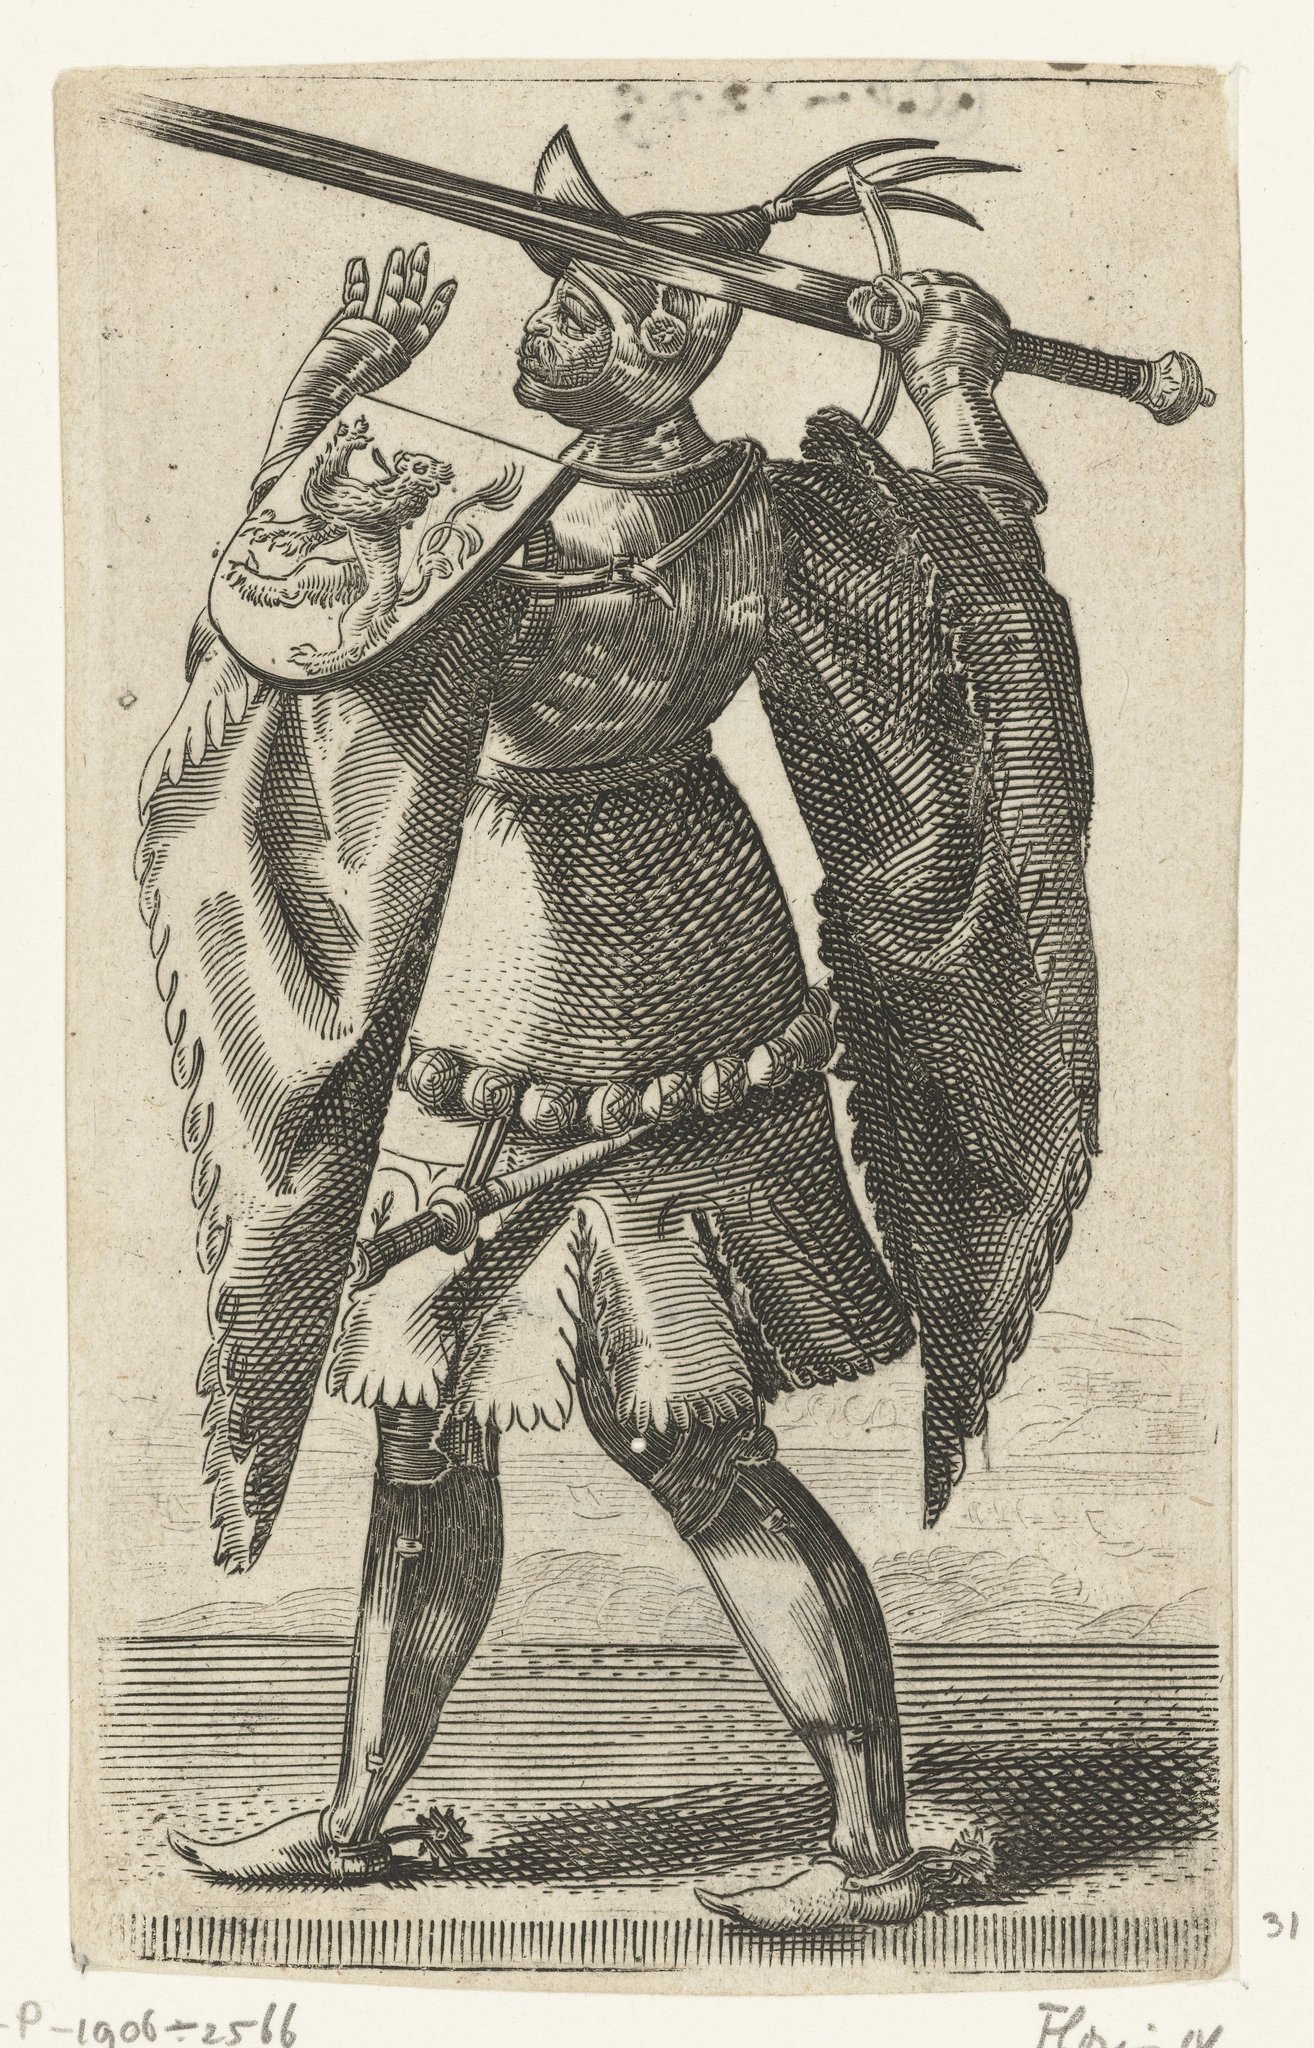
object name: print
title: Portret van Floris IV, graaf van Holland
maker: adriaen matham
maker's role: draughtsman, print maker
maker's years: 1599-1660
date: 1620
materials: paper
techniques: engraving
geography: haarlem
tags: floris iv (graaf van holland), nobility and patriciate; chivalry, knighthood, county of holland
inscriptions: collector's mark: Lugt 2228, name: ‘floris willems/ soon 13de graaf’, number: ‘1223’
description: Portret van Floris IV, graaf van Holland, staande in een harnas met op zijn schouder het wapen van Holland en in zijn hand een zwaard. Prent uit een serie van 36 prenten met portretten ten voeten uit van graven en gravinnen van Holland.